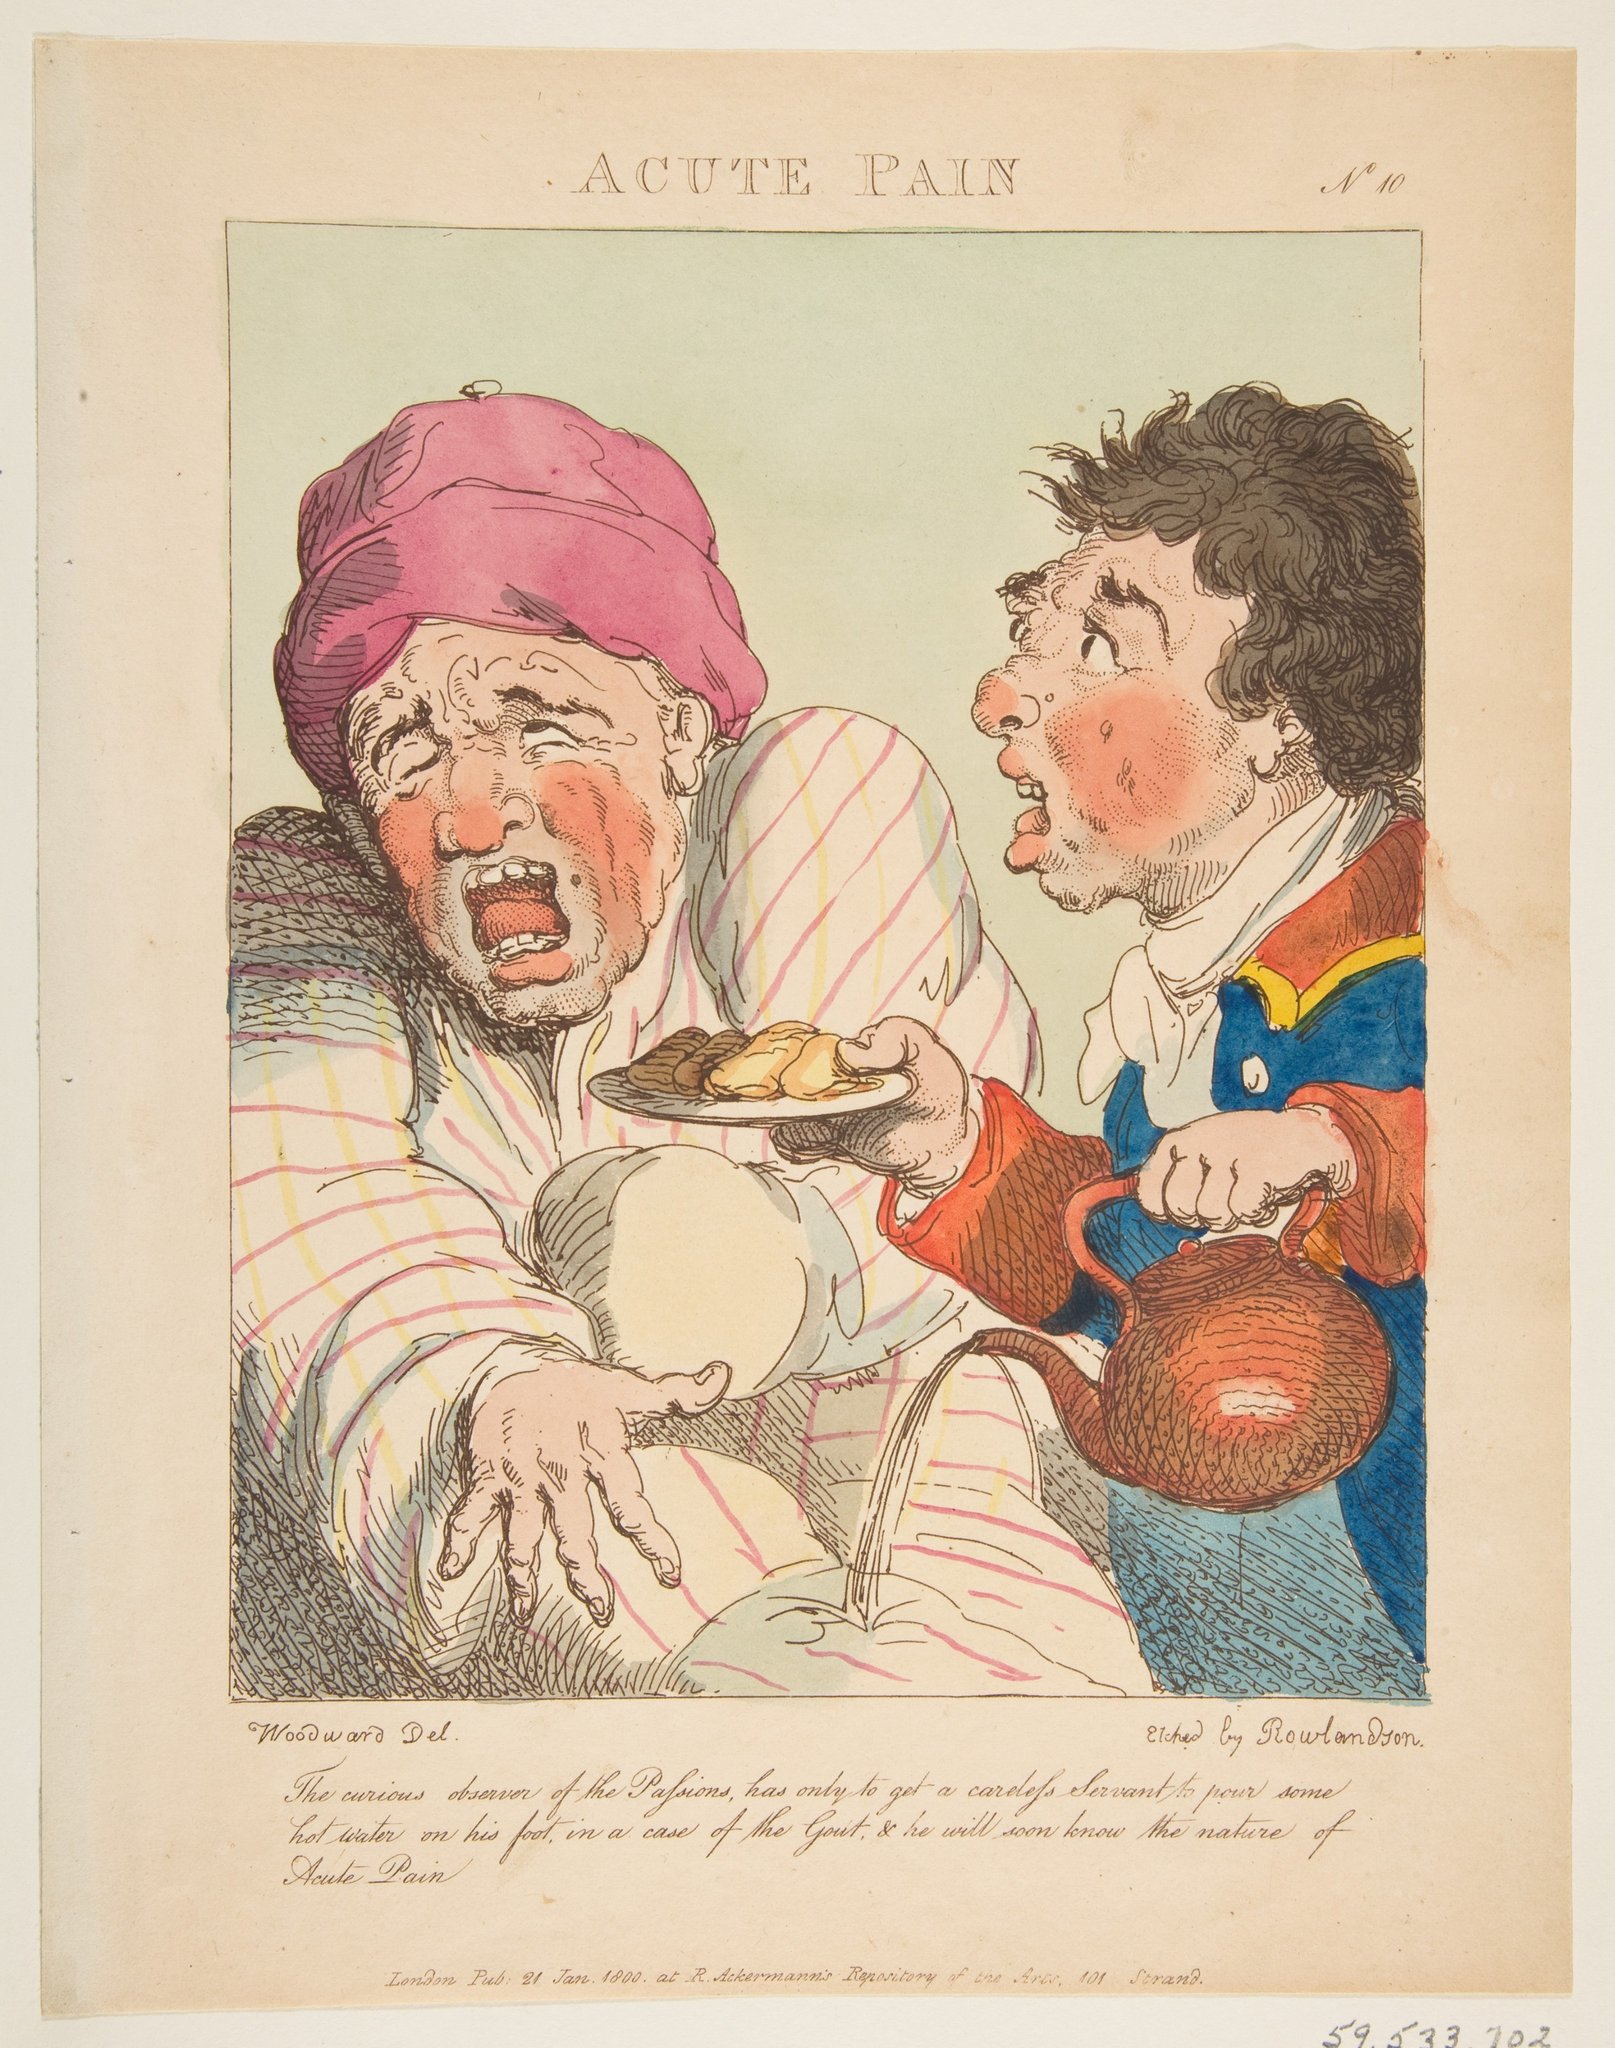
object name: print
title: Acute Pain (Le Brun Travested, or Caricatures of the Passions)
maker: thomas rowlandson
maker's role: artist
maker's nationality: british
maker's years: 1757-1827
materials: ink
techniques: etching, hand coloring, printing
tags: suffering,men